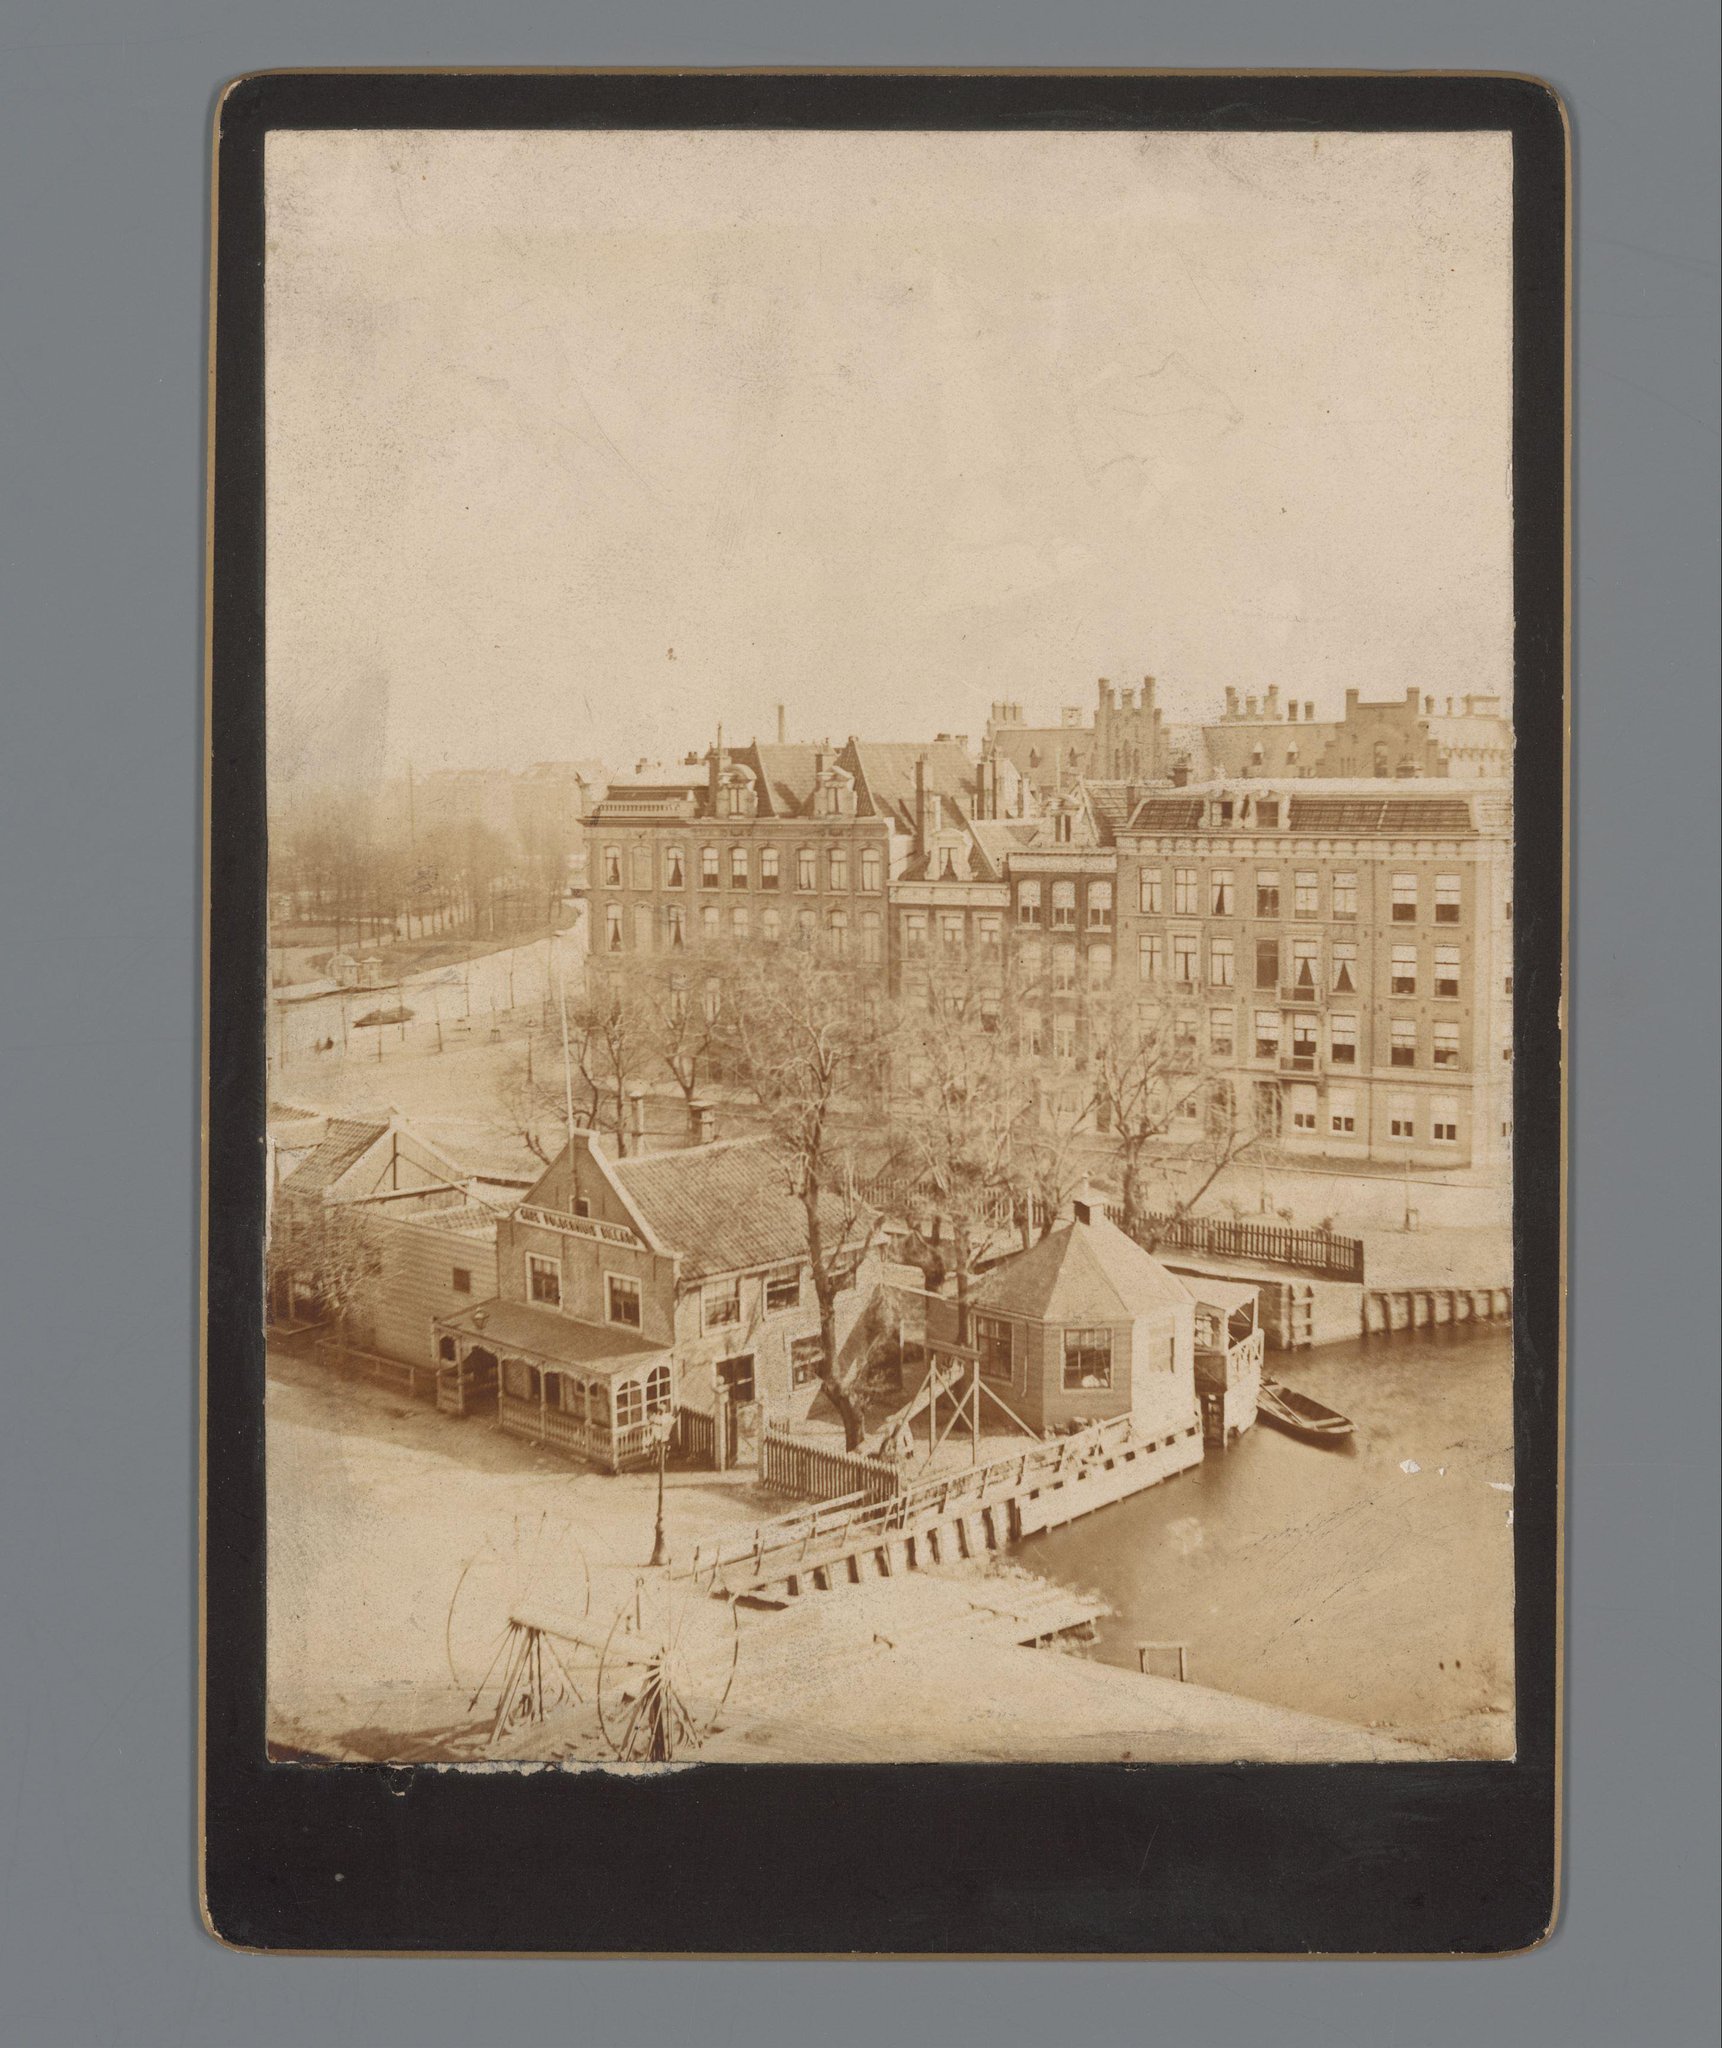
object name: photograph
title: Gezicht op Café Polderhuis vanaf het Rijksmuseum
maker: Anonymous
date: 1885-1920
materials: photographic support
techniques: gelatin silver print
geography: amsterdam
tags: city-view in general; 'veduta', inn, coffee-house, public house, etc.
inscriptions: annotation: ‘Rijksmuseum/ toren’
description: Gezicht op Café Polderhuis vanaf het Rijksmuseum. Het café lag op de hoek van de Stadhouderskade de Ruysdaelkade.